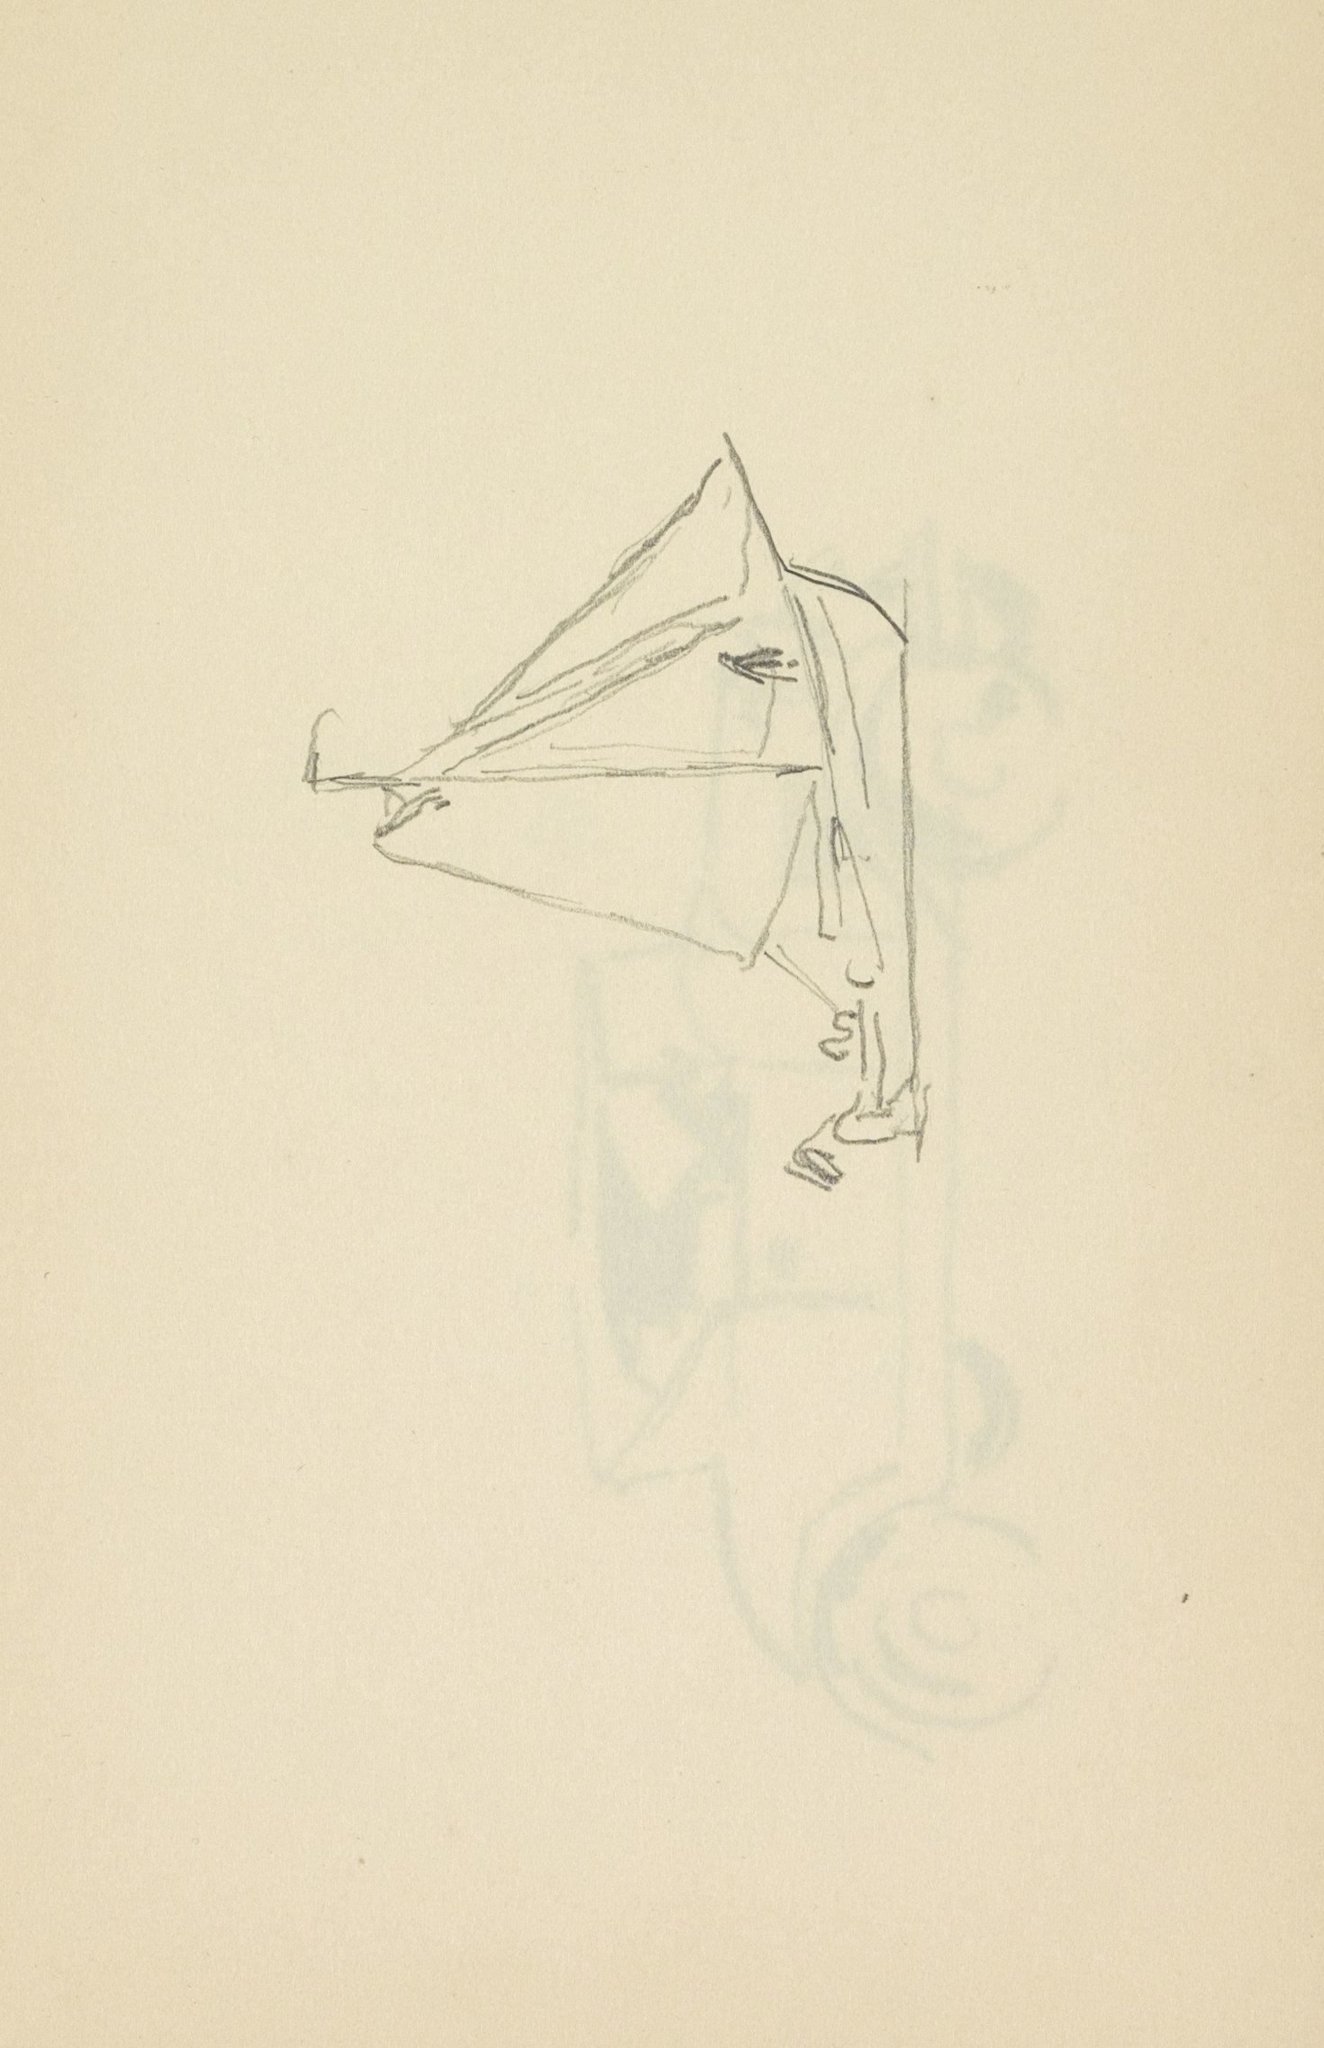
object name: sketchbook leaf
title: Zeilboot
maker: cornelis vreedenburgh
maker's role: draughtsman, print maker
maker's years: 1880-1946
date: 1890-1946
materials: paper, pencil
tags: sailing-ship, sailing-boat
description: Blad 39 recto uit een schetsboek met 73 bladen.